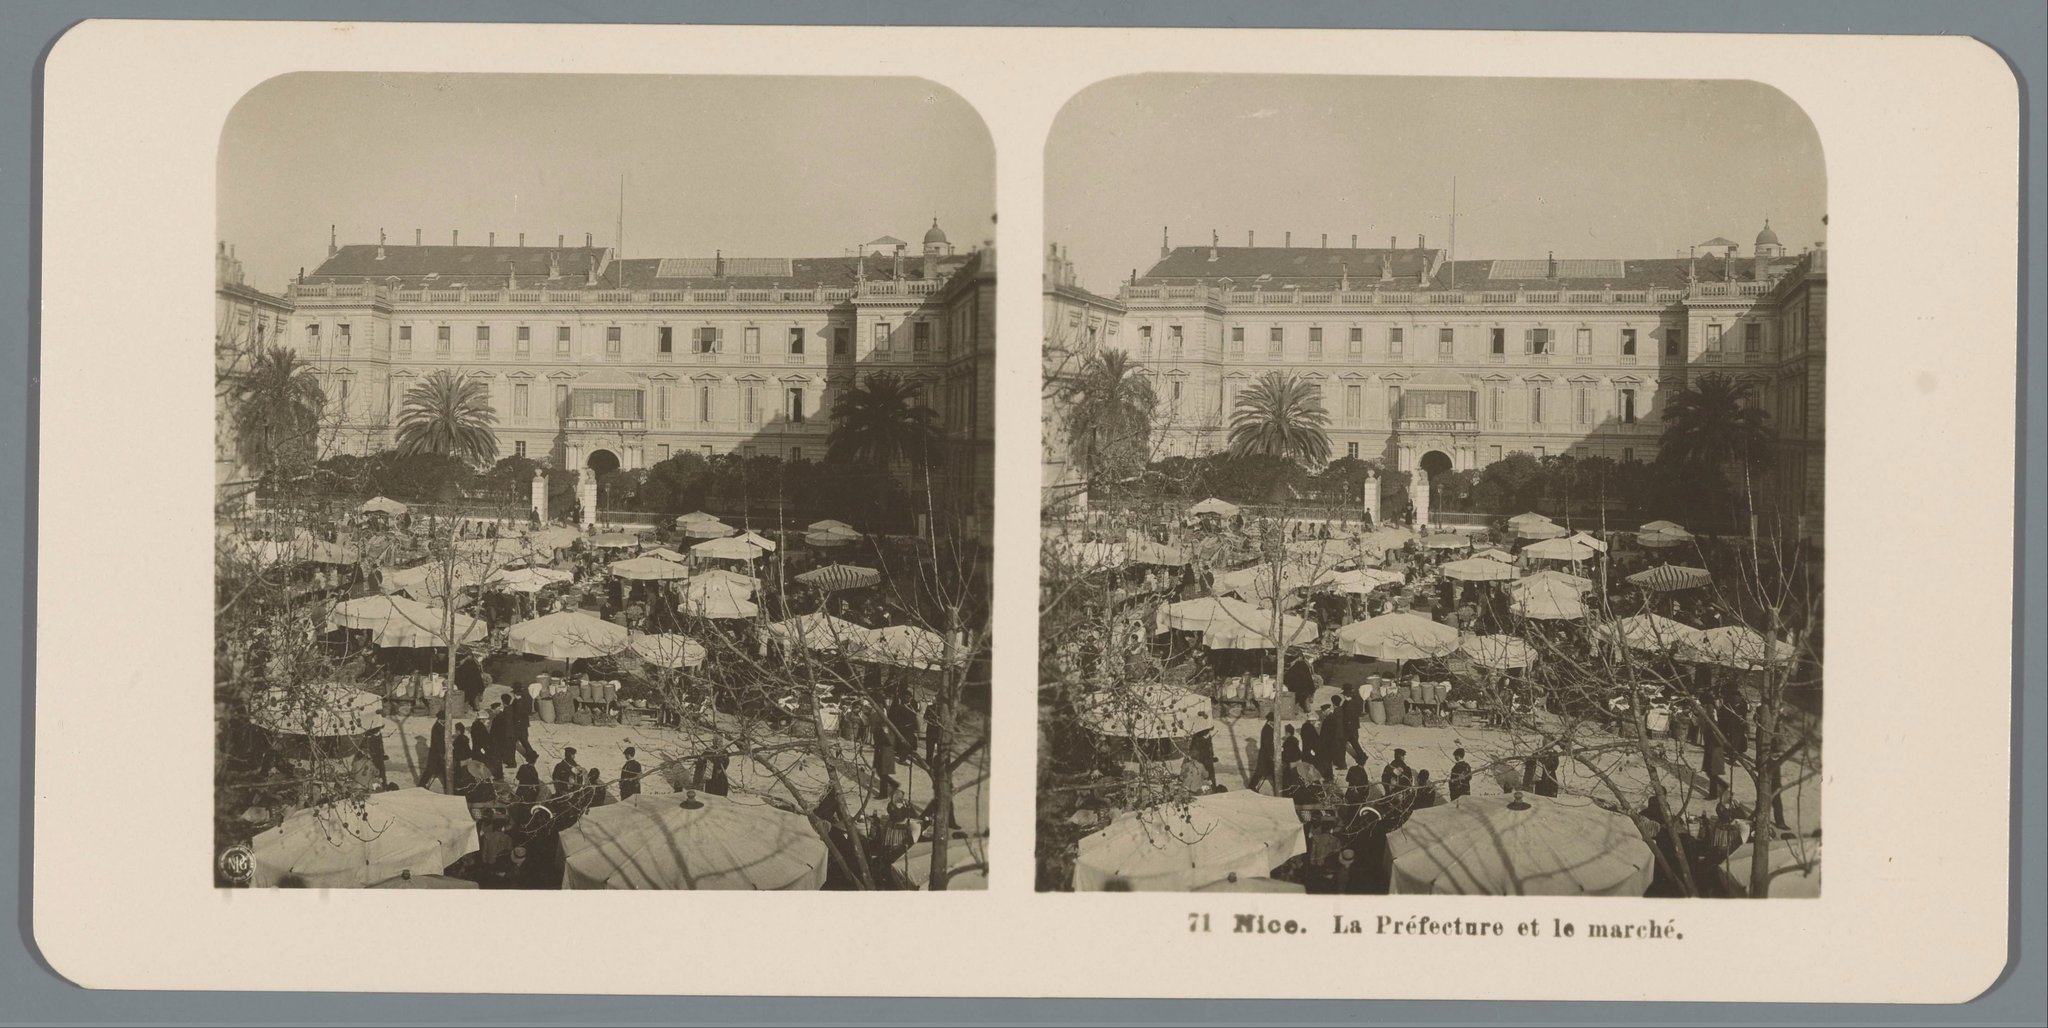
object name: stereograph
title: Gezicht op de markt van Nice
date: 1904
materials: cardboard, photographic support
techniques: gelatin silver print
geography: nice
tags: market, façade (of house or building), village square, place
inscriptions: number: ‘71’, inscription: ‘NPG’